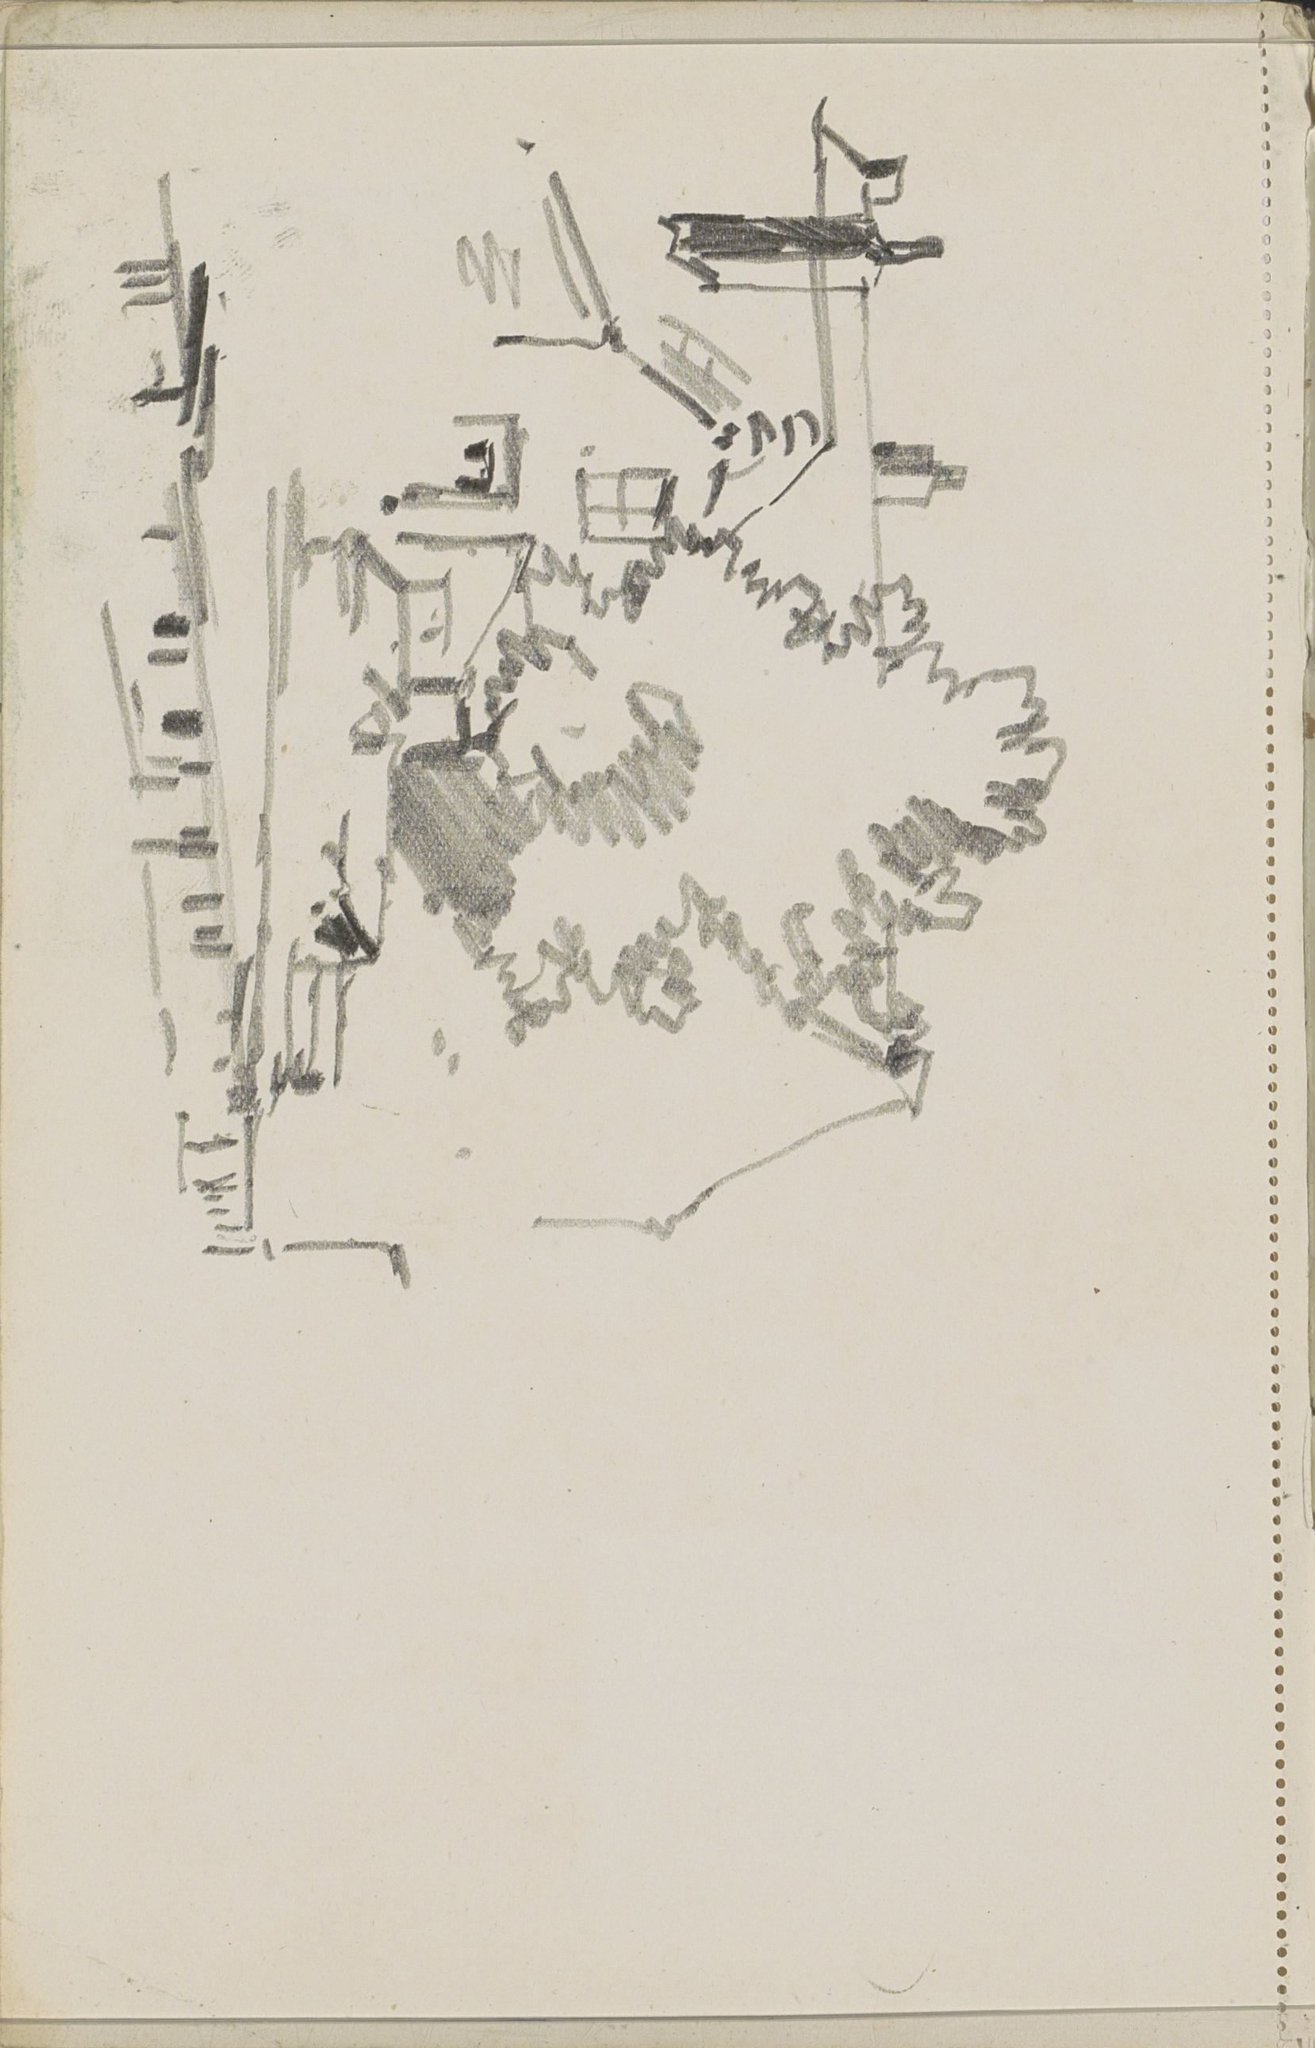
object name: sketchbook leaf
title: Boom tussen de huizen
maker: cornelis vreedenburgh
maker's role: draughtsman, print maker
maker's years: 1880-1946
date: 1890-1946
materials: paper, pencil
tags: housing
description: Blad 60 verso uit een schetsboek met 61 bladen.